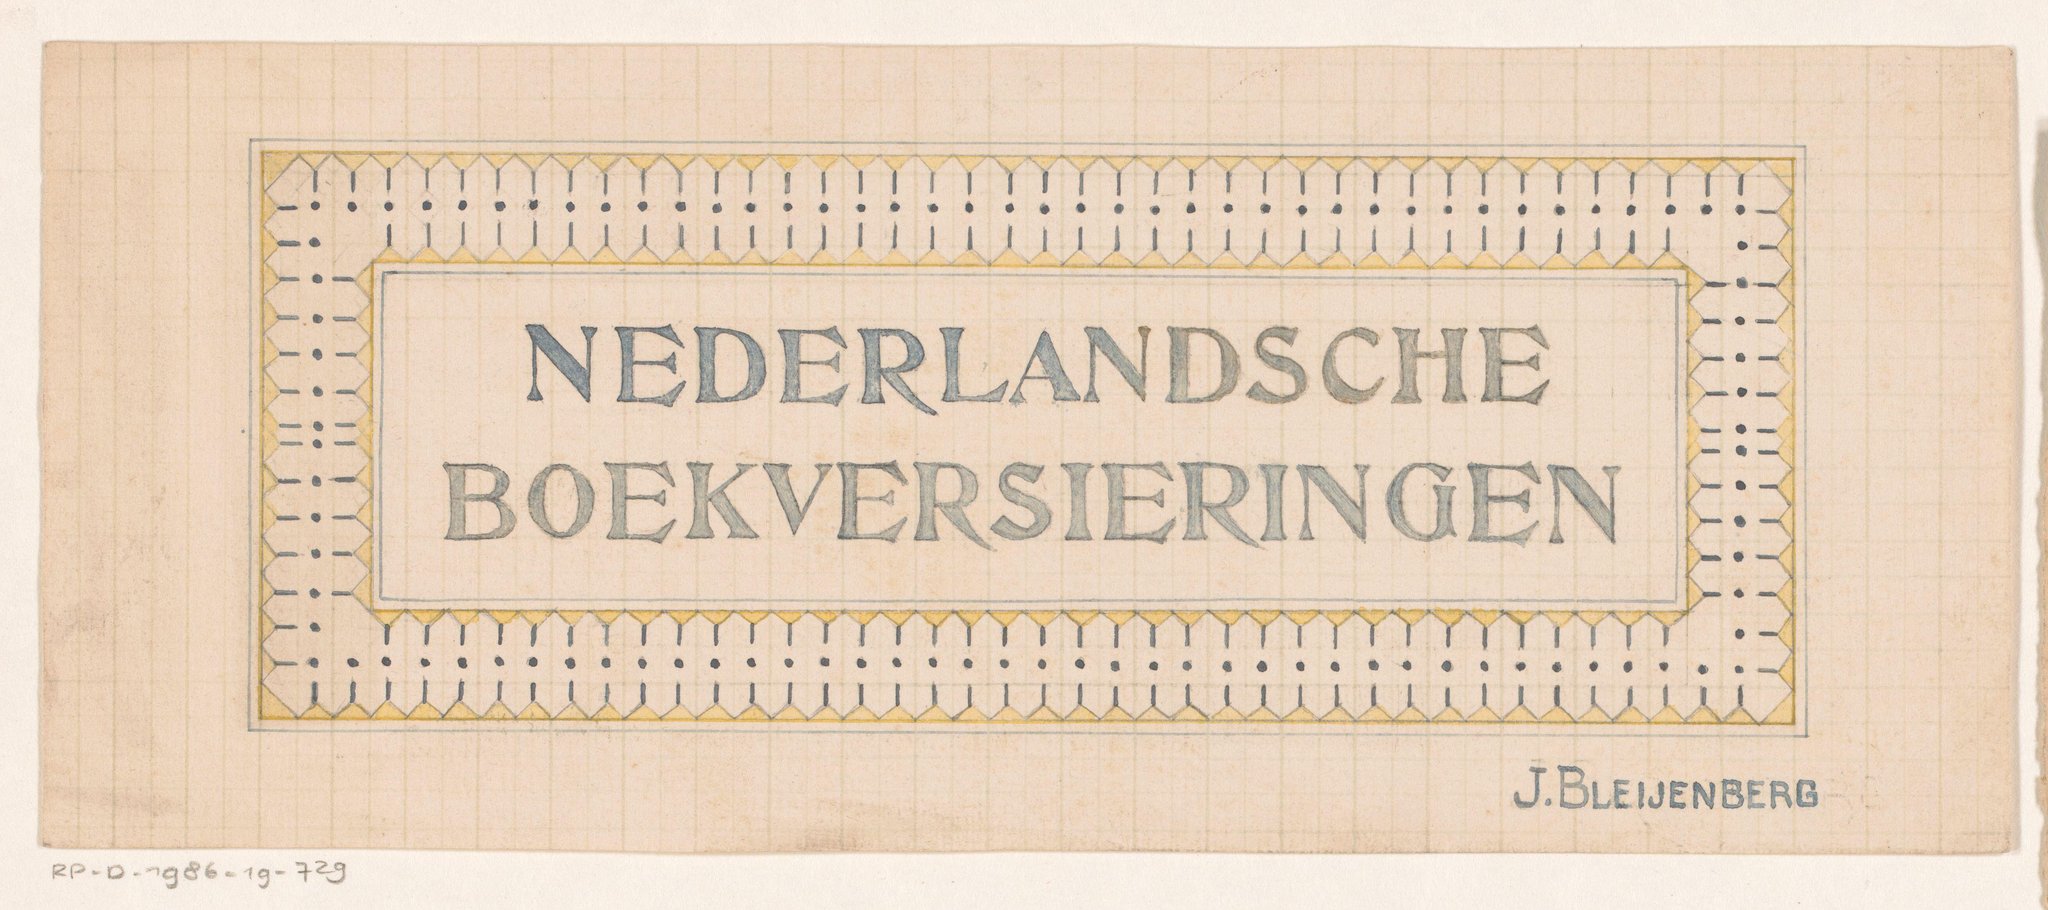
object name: drawing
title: Kader met de tekst 'Nederlandsche boekversieringen'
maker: reinier willem petrus de vries (1874-1953)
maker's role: draughtsman, print maker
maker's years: 1874-1953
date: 1884-1952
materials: pencil, watercolor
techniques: brush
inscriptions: collector's mark: ‘R:MVS.’, name: ‘J. Bleijenberg’